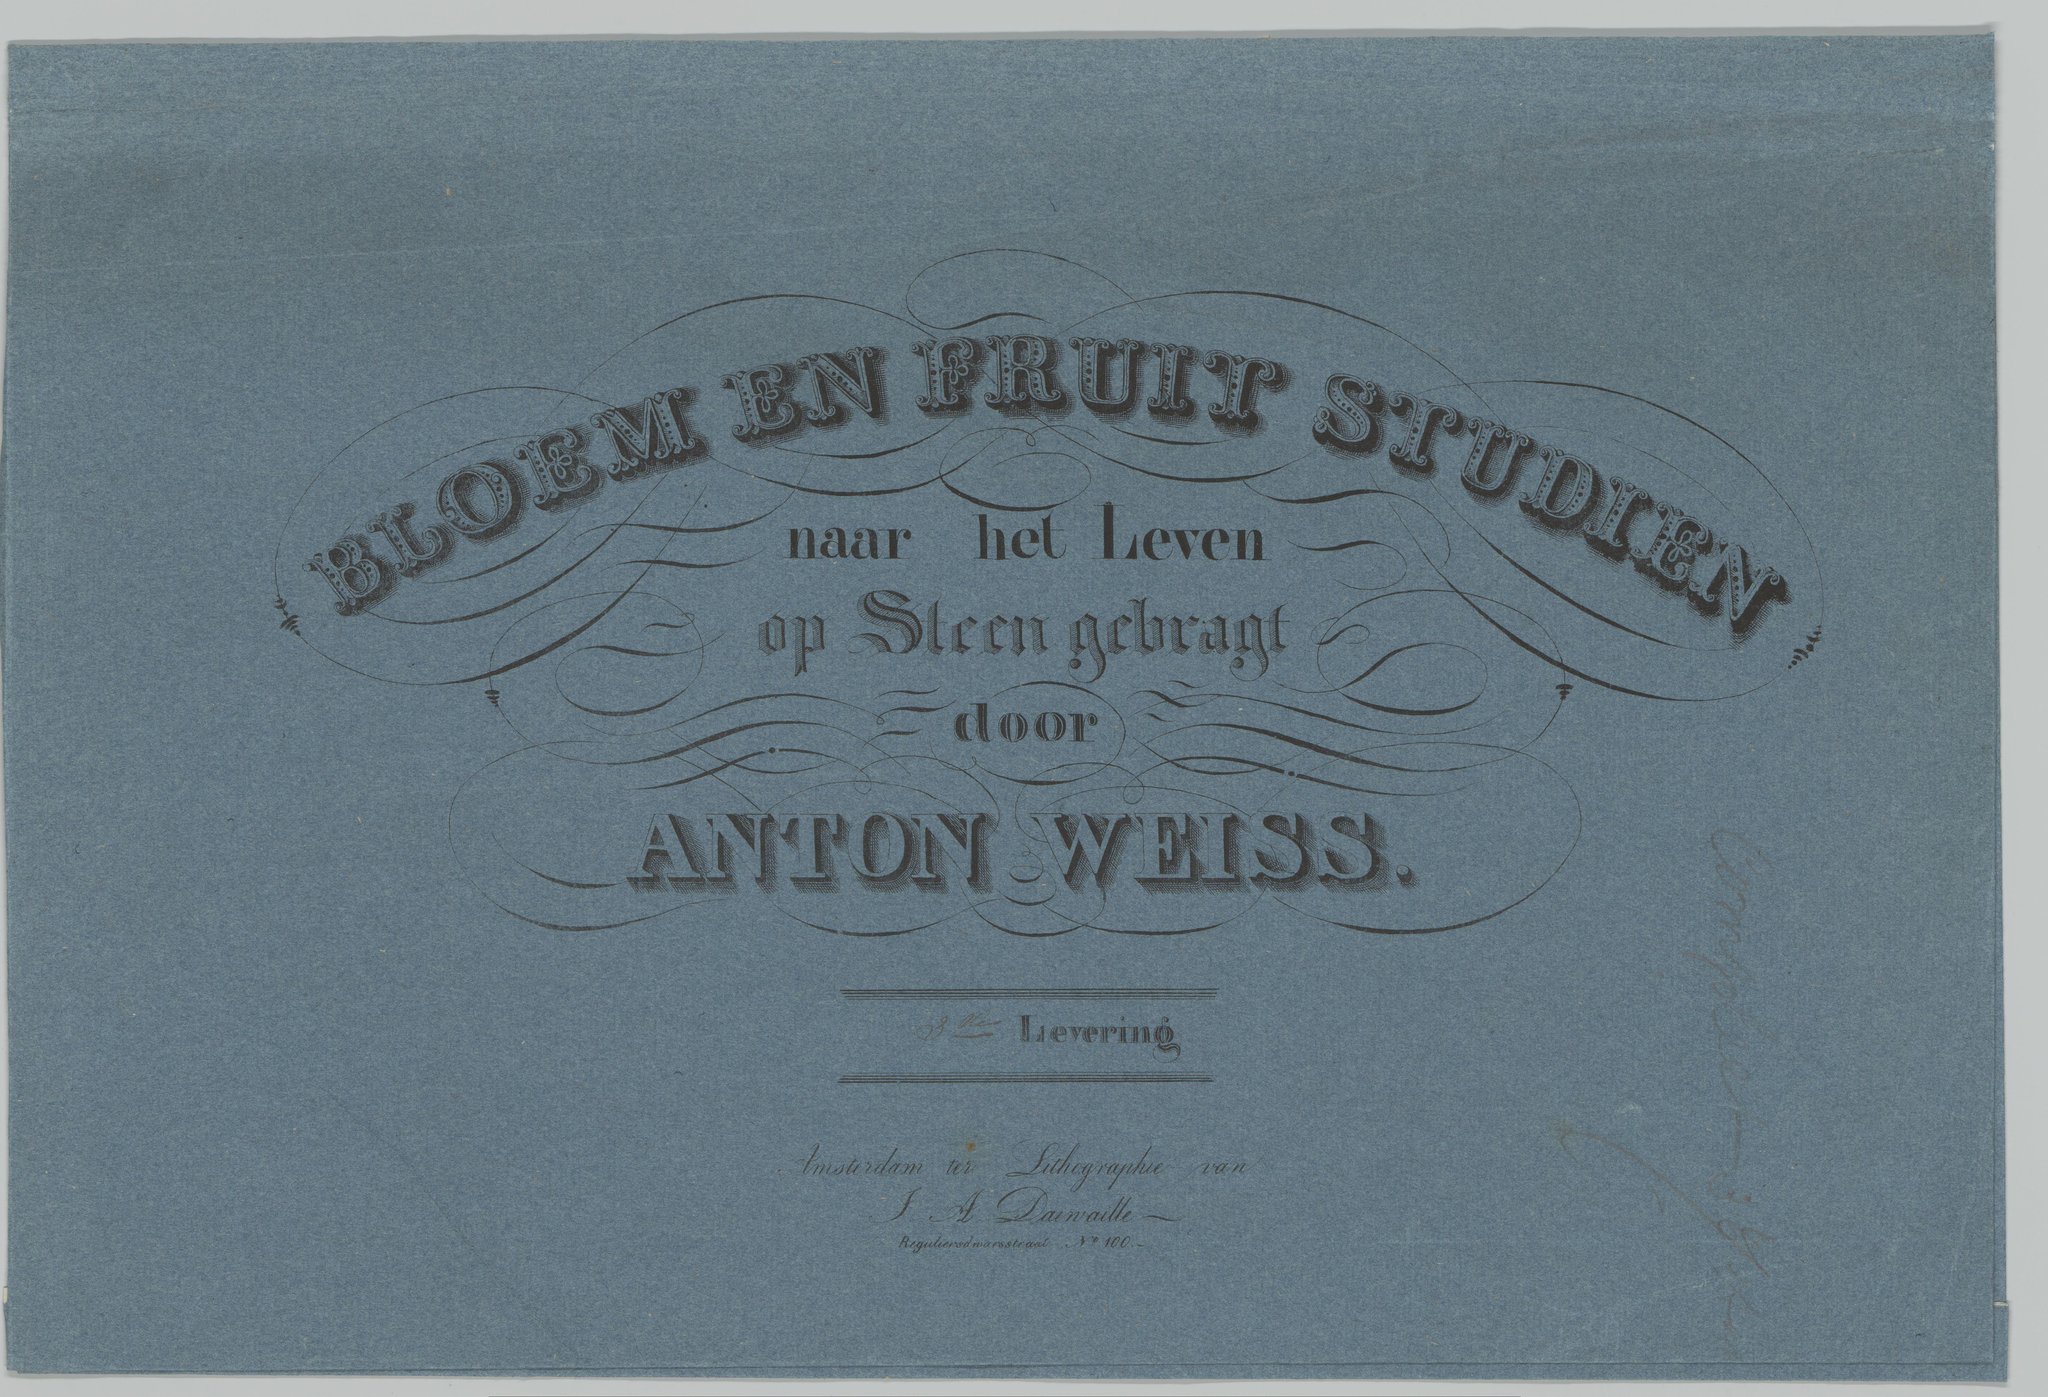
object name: wrapper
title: Bloem en Fruit Studien (...) 3de aflevering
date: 1820-1833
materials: paper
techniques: lithograph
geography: amsterdam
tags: flowers, fruits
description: Omslag met twee incomplete series lithografieën van bloemen en fruit en proefdrukken daarvan. Eén serie bevat de nummers 2 t/m 36, nummers 1, 4 en 31 ontbreken. Eén serie bevat de nummers 1 t/m 36, nummers 3, 6, 7, 9, 10 en 27 ontbreken, nummer 17 bestaat in twee varianten. Daarnaast zijn er proefdrukken van de nummers 1, 2, 3 (twee maal), 4, 7 t/m 10, 12 en 27 en een fruitstuk dat vermoedelijk niet tot de serie behoort. In totaal zijn dit zesenzeventig lithografieën.